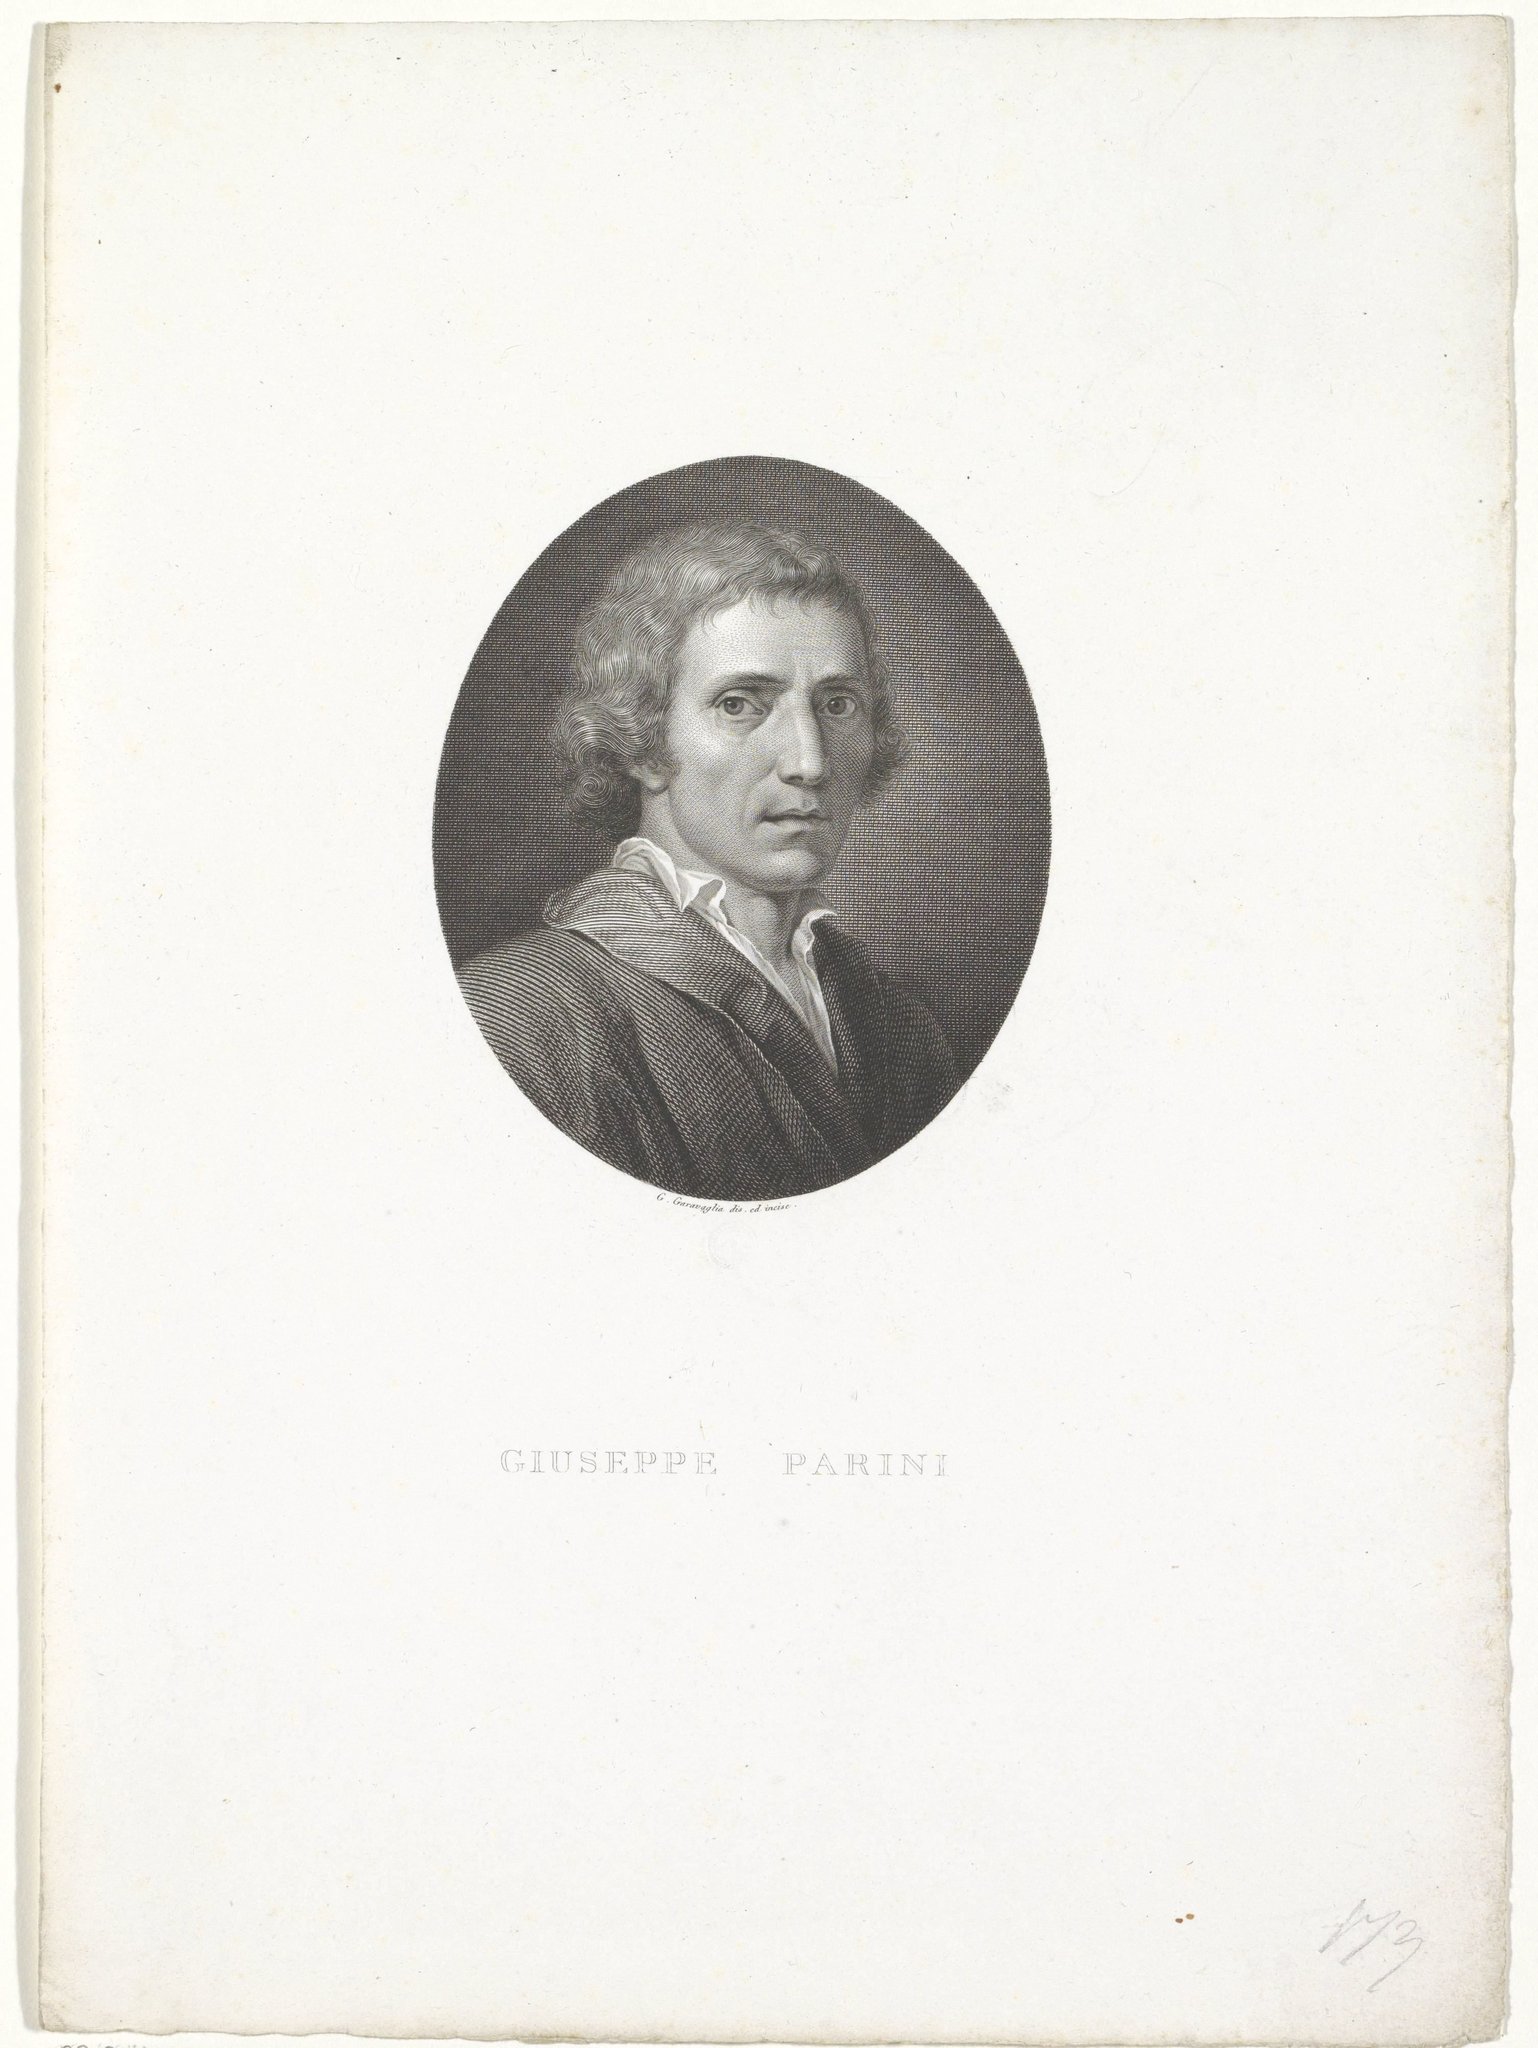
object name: print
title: Portretten van beroemde Italianen in ovalen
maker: giovita garavaglia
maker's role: print maker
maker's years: 1790-1835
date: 1800-1835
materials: paper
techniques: engraving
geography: italy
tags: historical persons, portrait of a writer, writer, poet, author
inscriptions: collector's mark: Lugt 4187, collector's mark: Lugt 2228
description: Deze prent maakt deel uit van een reeks portretprenten van onbekende omvang. De reeks is in meerdere staten uitgegeven. De eerste staat met enkel het portret in ovaal. Een tweede staat met naam van de geportretteerde in holle letters onder de voorstelling. Een derde staat met de naam van de geportretteerde in gevulde letters onder de voorstelling. En een vierde staat met een rechthoekig kader rondom het ovale portret.